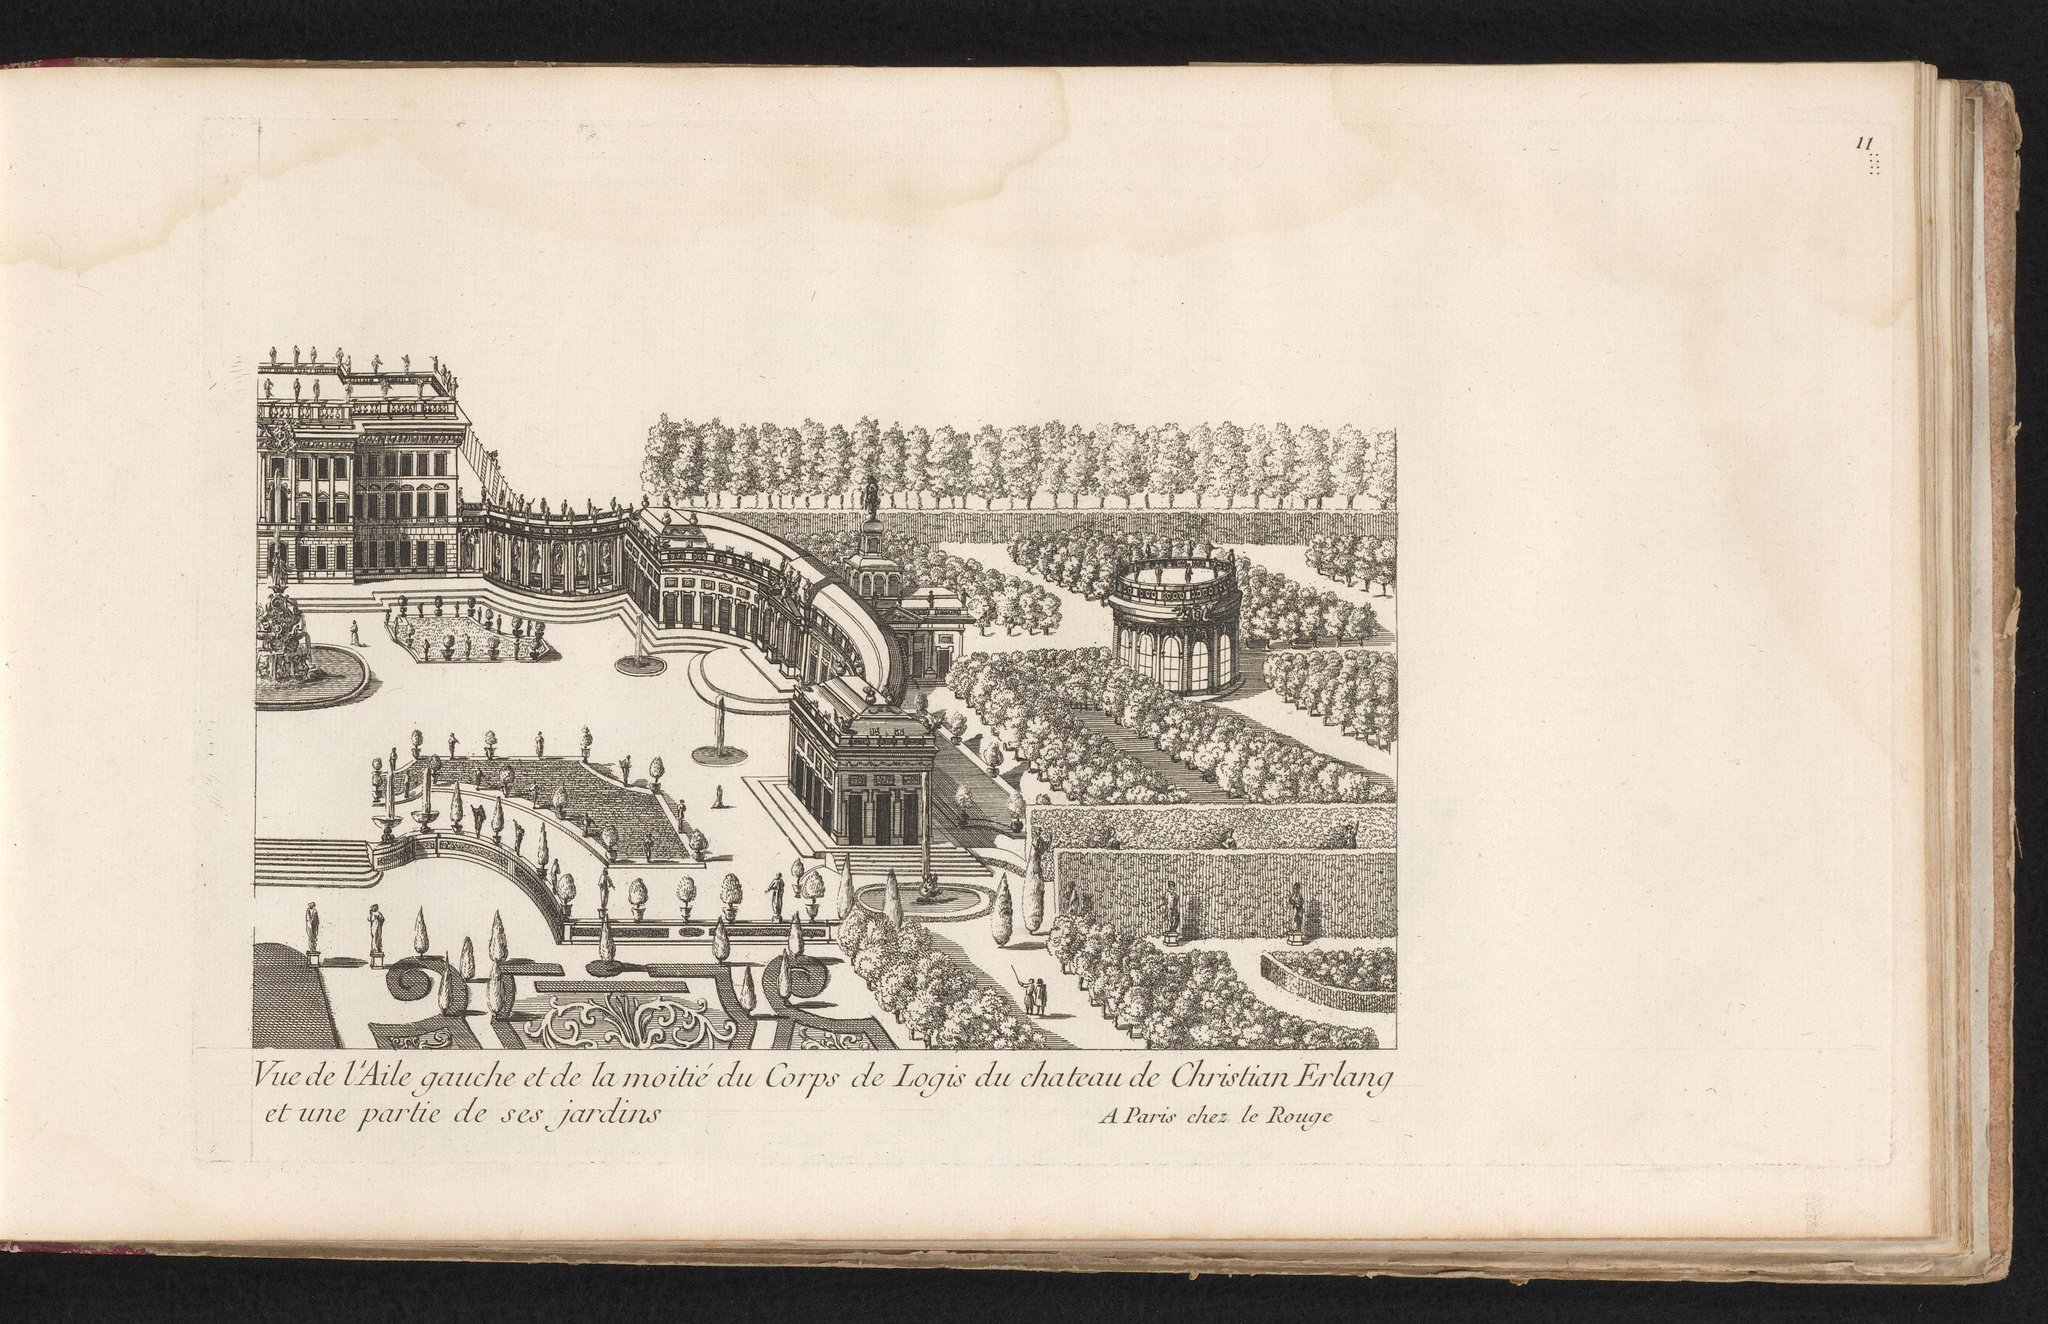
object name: print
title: Vue de l'aile gauche et de la moitié du corps de logis du chateau de Christian Erlang et une partie de ses jardins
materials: paper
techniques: engraving, etching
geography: paris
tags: plan, map of garden, palace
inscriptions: collector's mark: Lugt 2228, collector's mark: Lugt 2760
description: De serie 'Jardins anglo-chinois à la mode' verscheen in totaal in 21 zogeheten 'cahiers' (afleveringen). De huidige prent komt uit het achtste 'cahier'. Het Rijksmuseum Amsterdam bezit drie banden met daarin in totaal zes 'cahiers' van deze reeks. In de documentatie wordt verwezen naar een in de bibliotheek van het Rijksmuseum Amsterdam aanwezige facsimile van het complete werk.